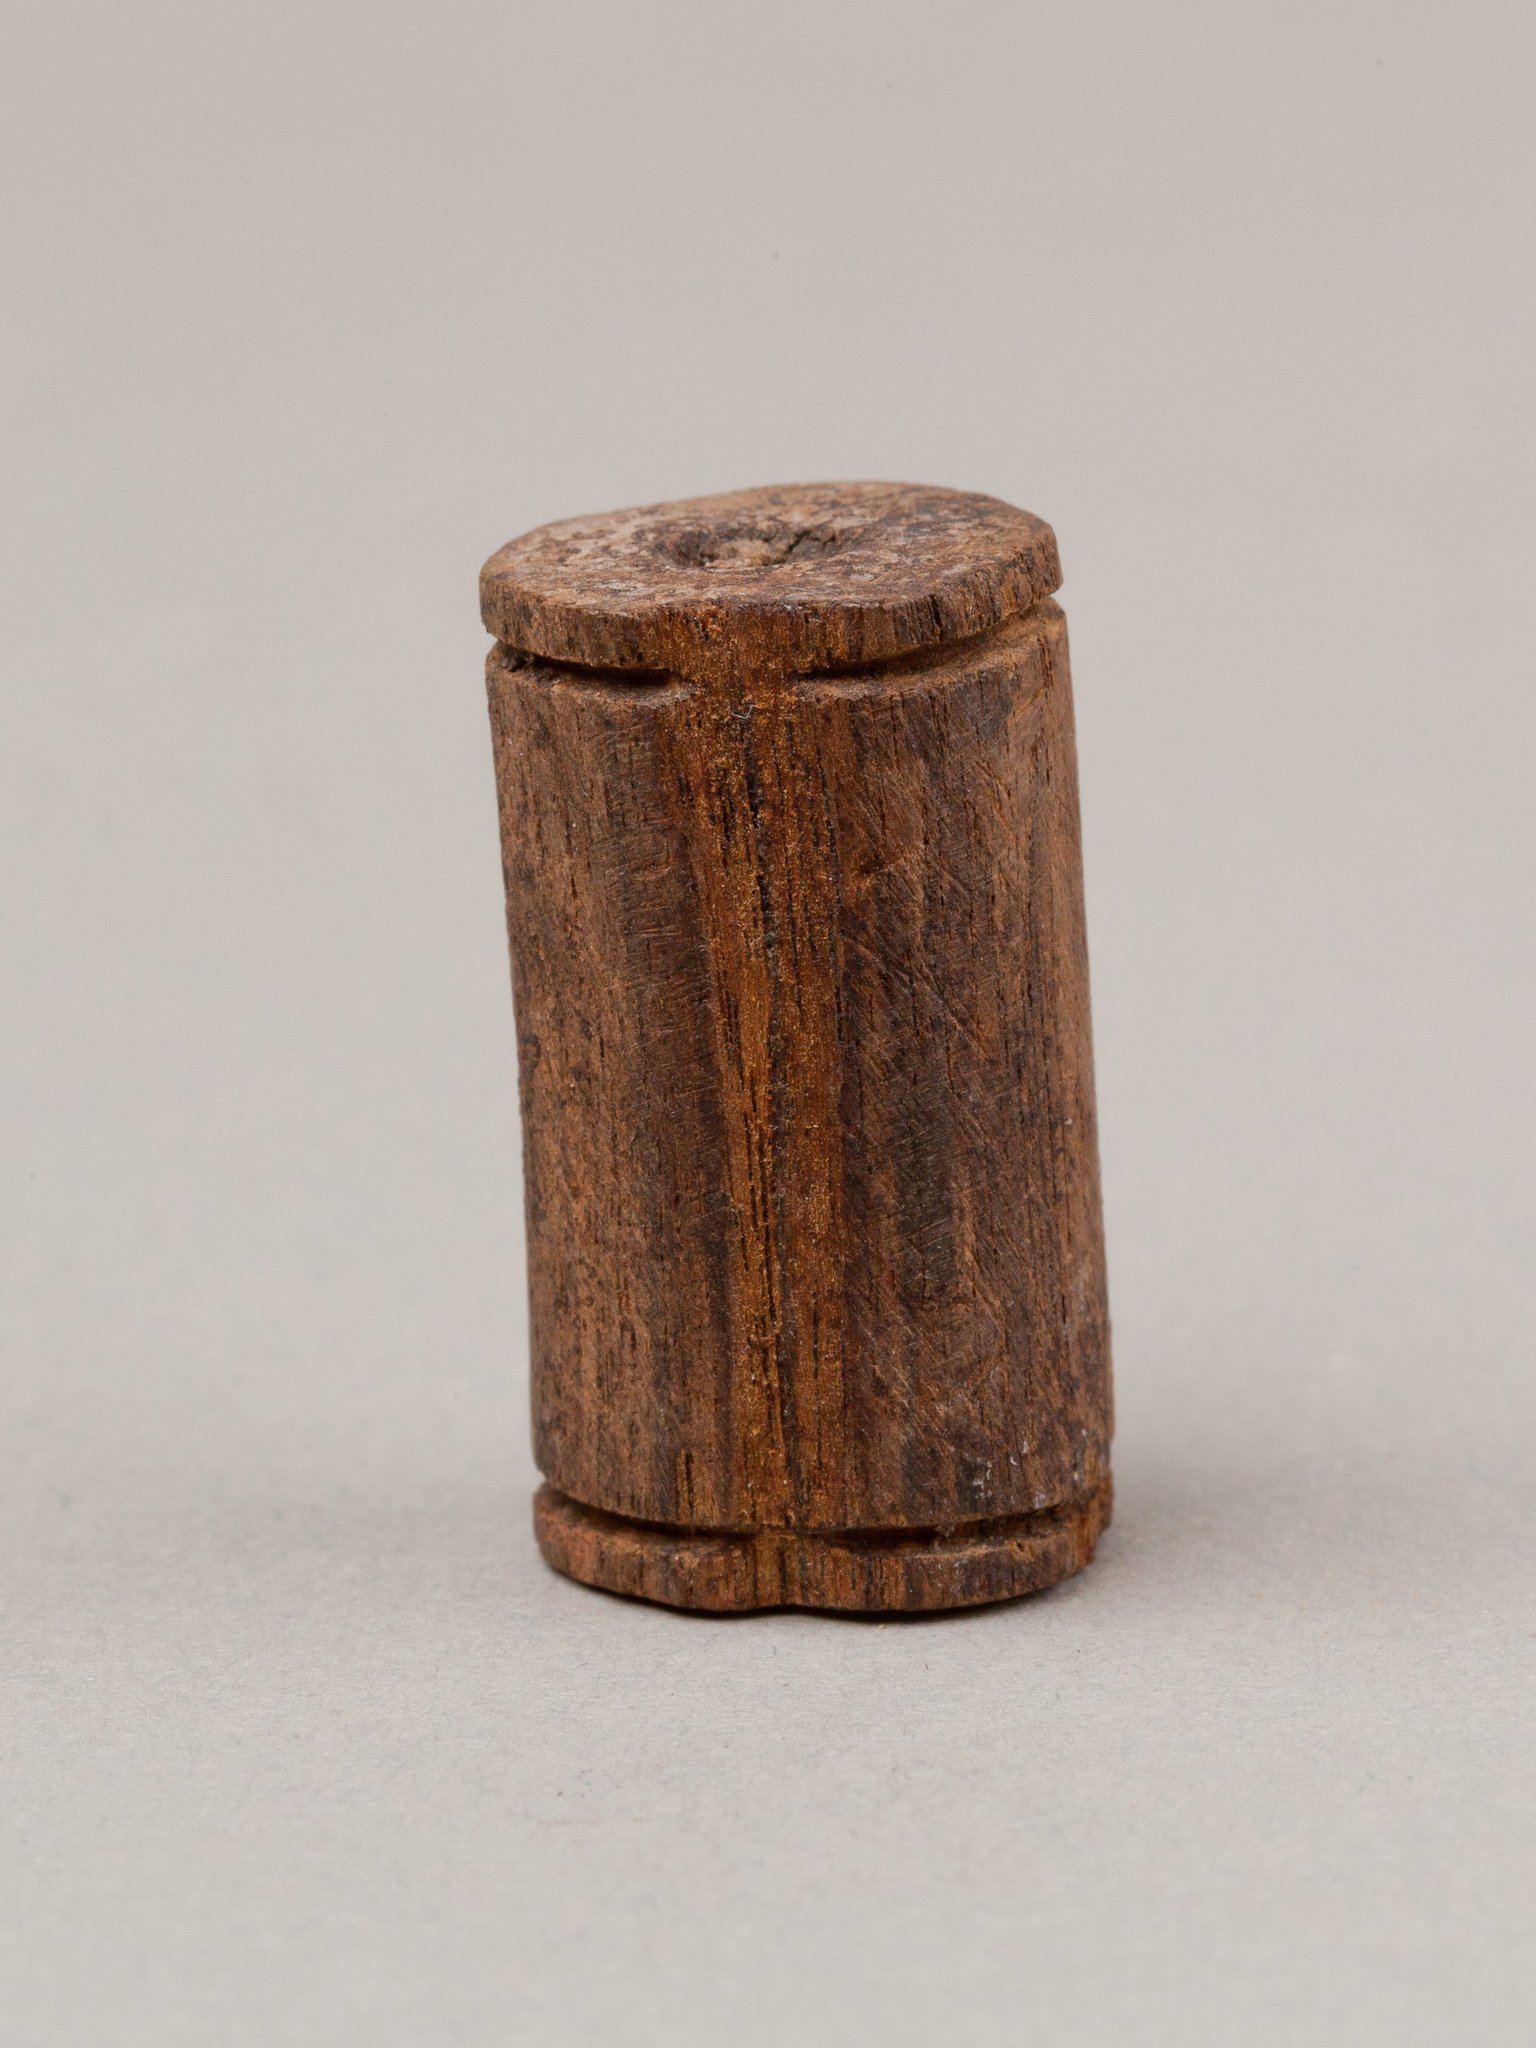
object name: cylinder seal, uninscribed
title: Uninscribed cylinder seal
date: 3100 BCE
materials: wood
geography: egypt